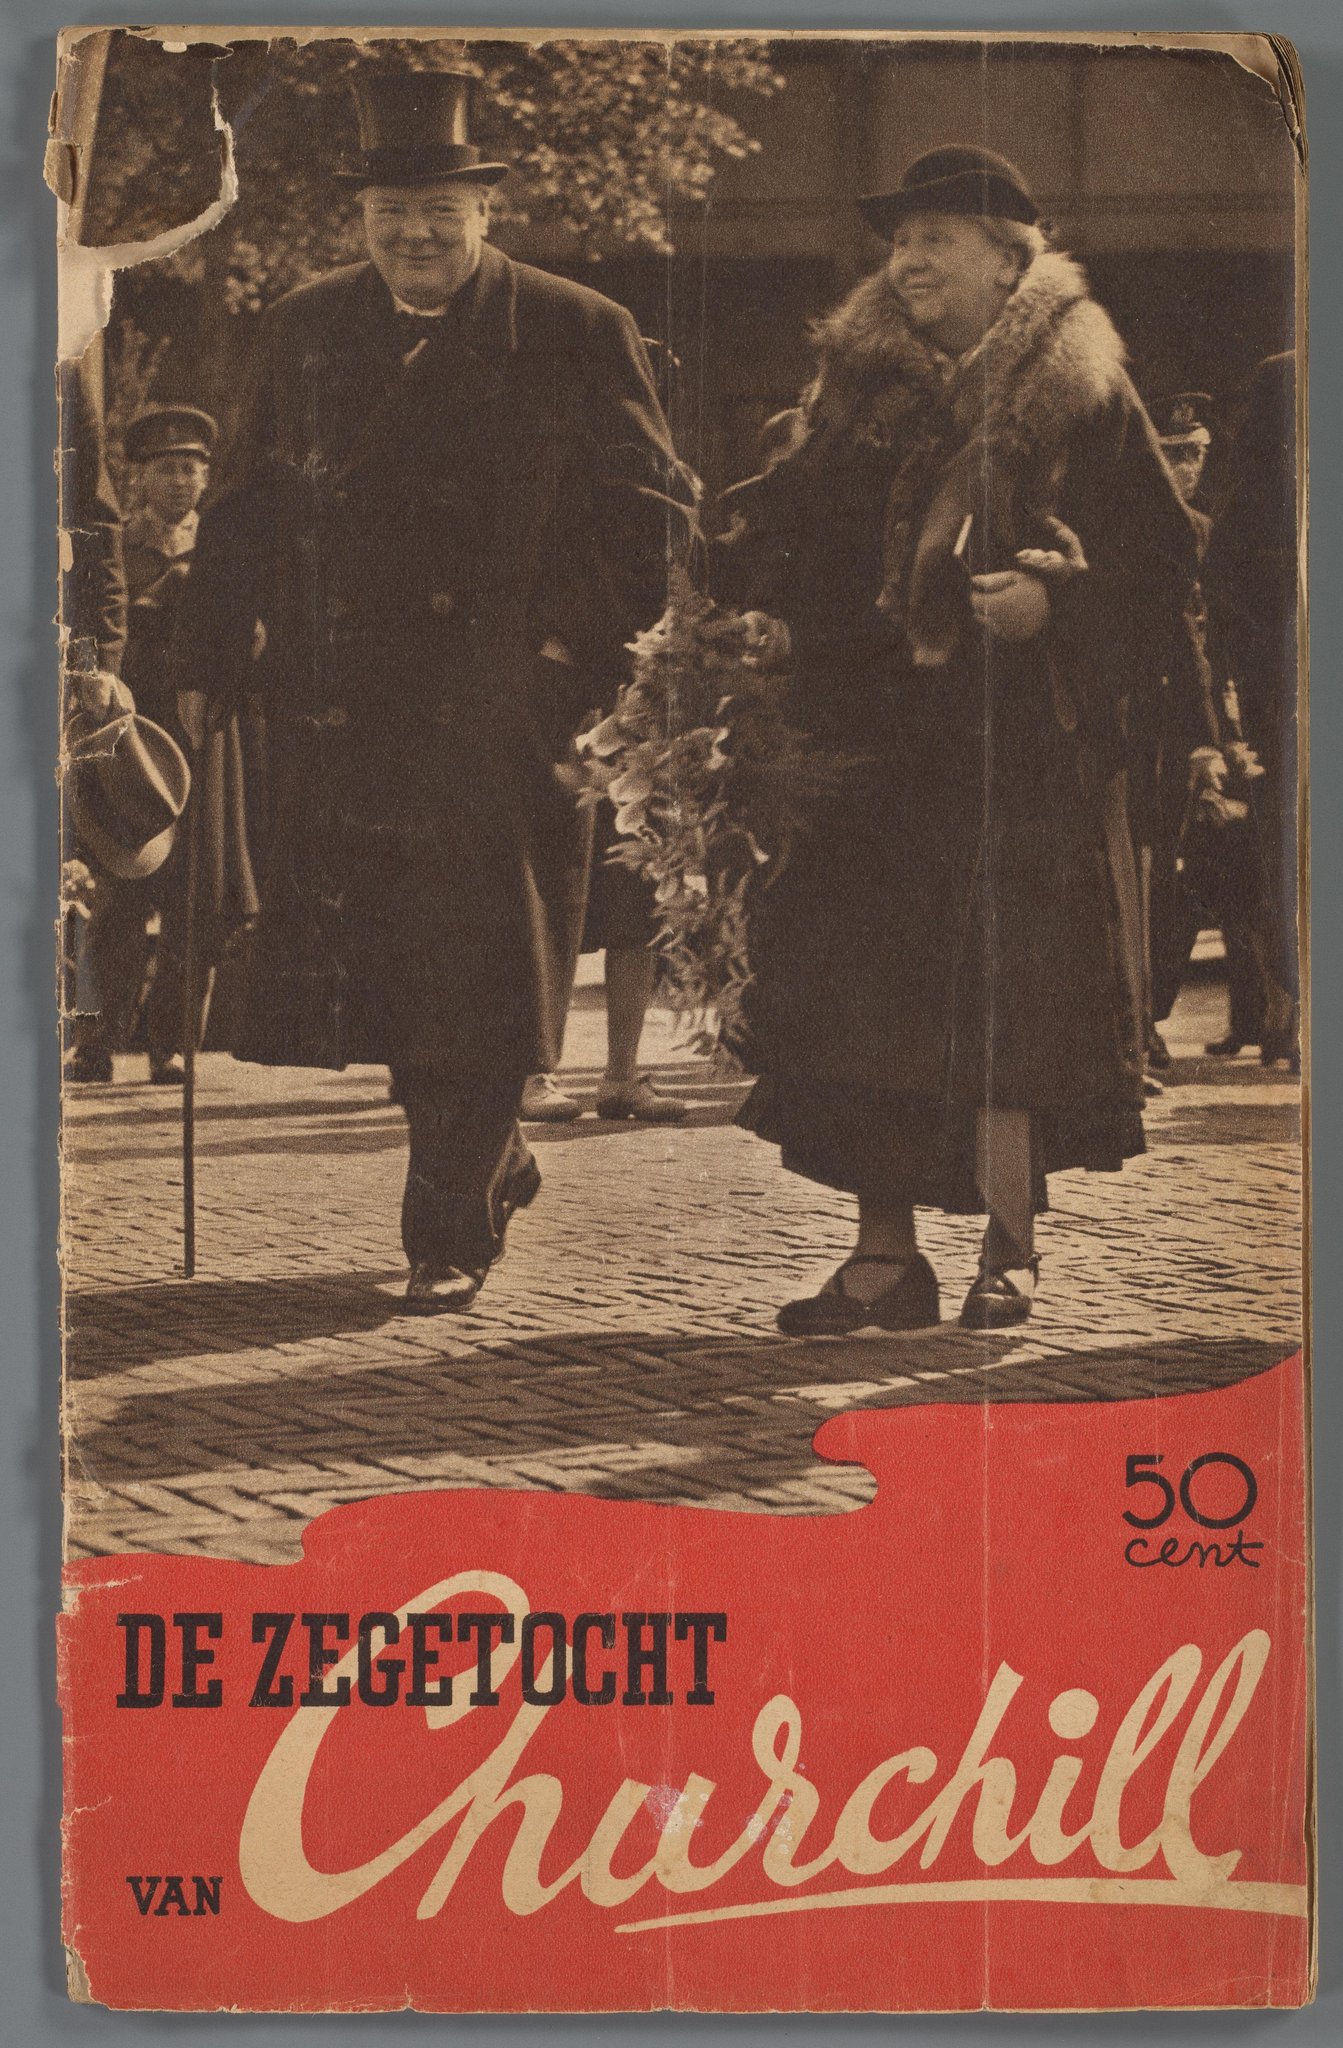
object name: brochure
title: De zegetocht van Churchill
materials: paper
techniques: printing, rotogravure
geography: haarlem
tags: the hague, print maker, wilhelmina of the netherlands, utrecht, bernhard (prins der nederlanden), beatrix (koningin der nederlanden), london, juliana of the netherlands, triumphal entry and public reception, pageant, 'entrée solennelle', 'joyeuse entrée', netherlands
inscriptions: inscription: ‘Met hartelijke groeten van Mary’, copyright notice: ‘Copyright: "Particam".’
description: Reportage over het bezoek tussen 8 en 13 mei 1946 van Winston Churchill aan Nederland.